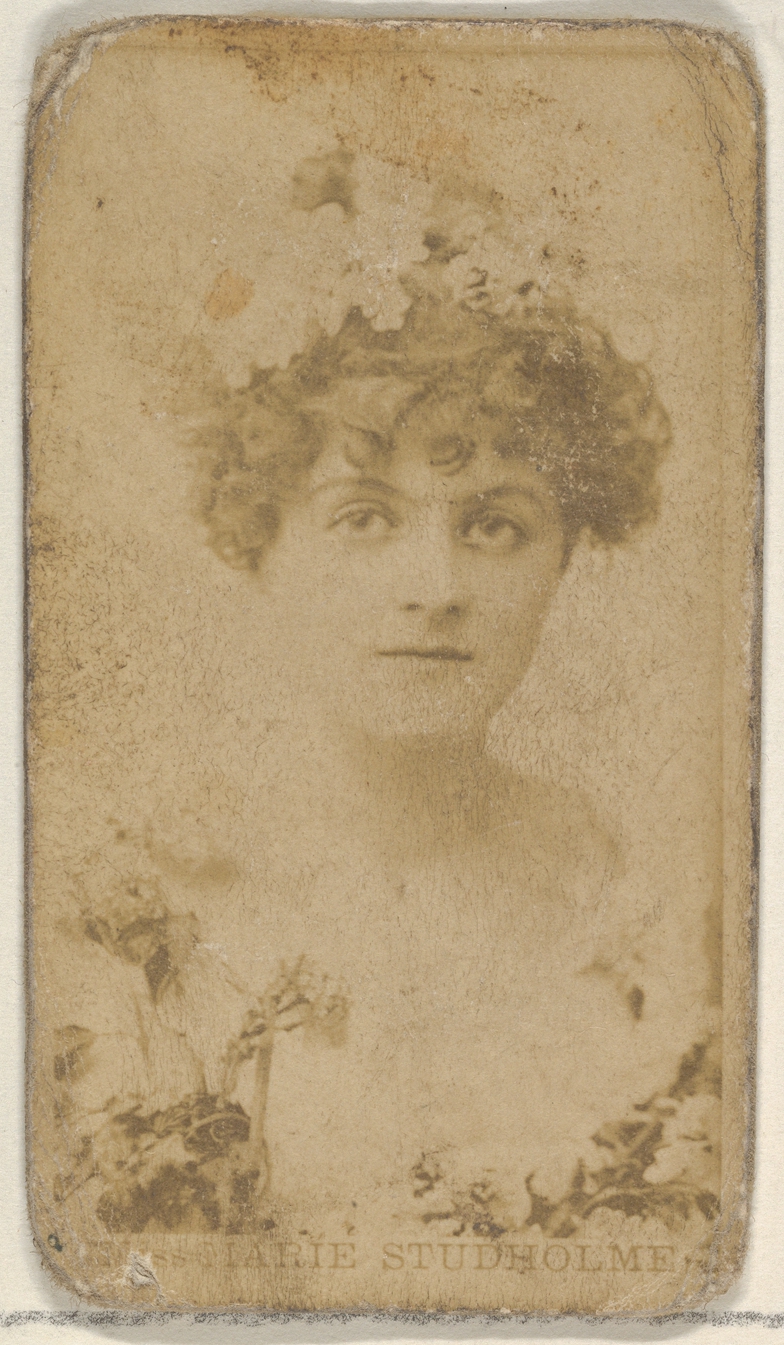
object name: photograph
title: Marie Studholme, from the Actors and Actresses series (N45, Type 8) for Virginia Brights Cigarettes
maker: allen & ginter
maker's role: publisher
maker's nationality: american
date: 1888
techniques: albumen silver print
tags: portraits,women,actresses